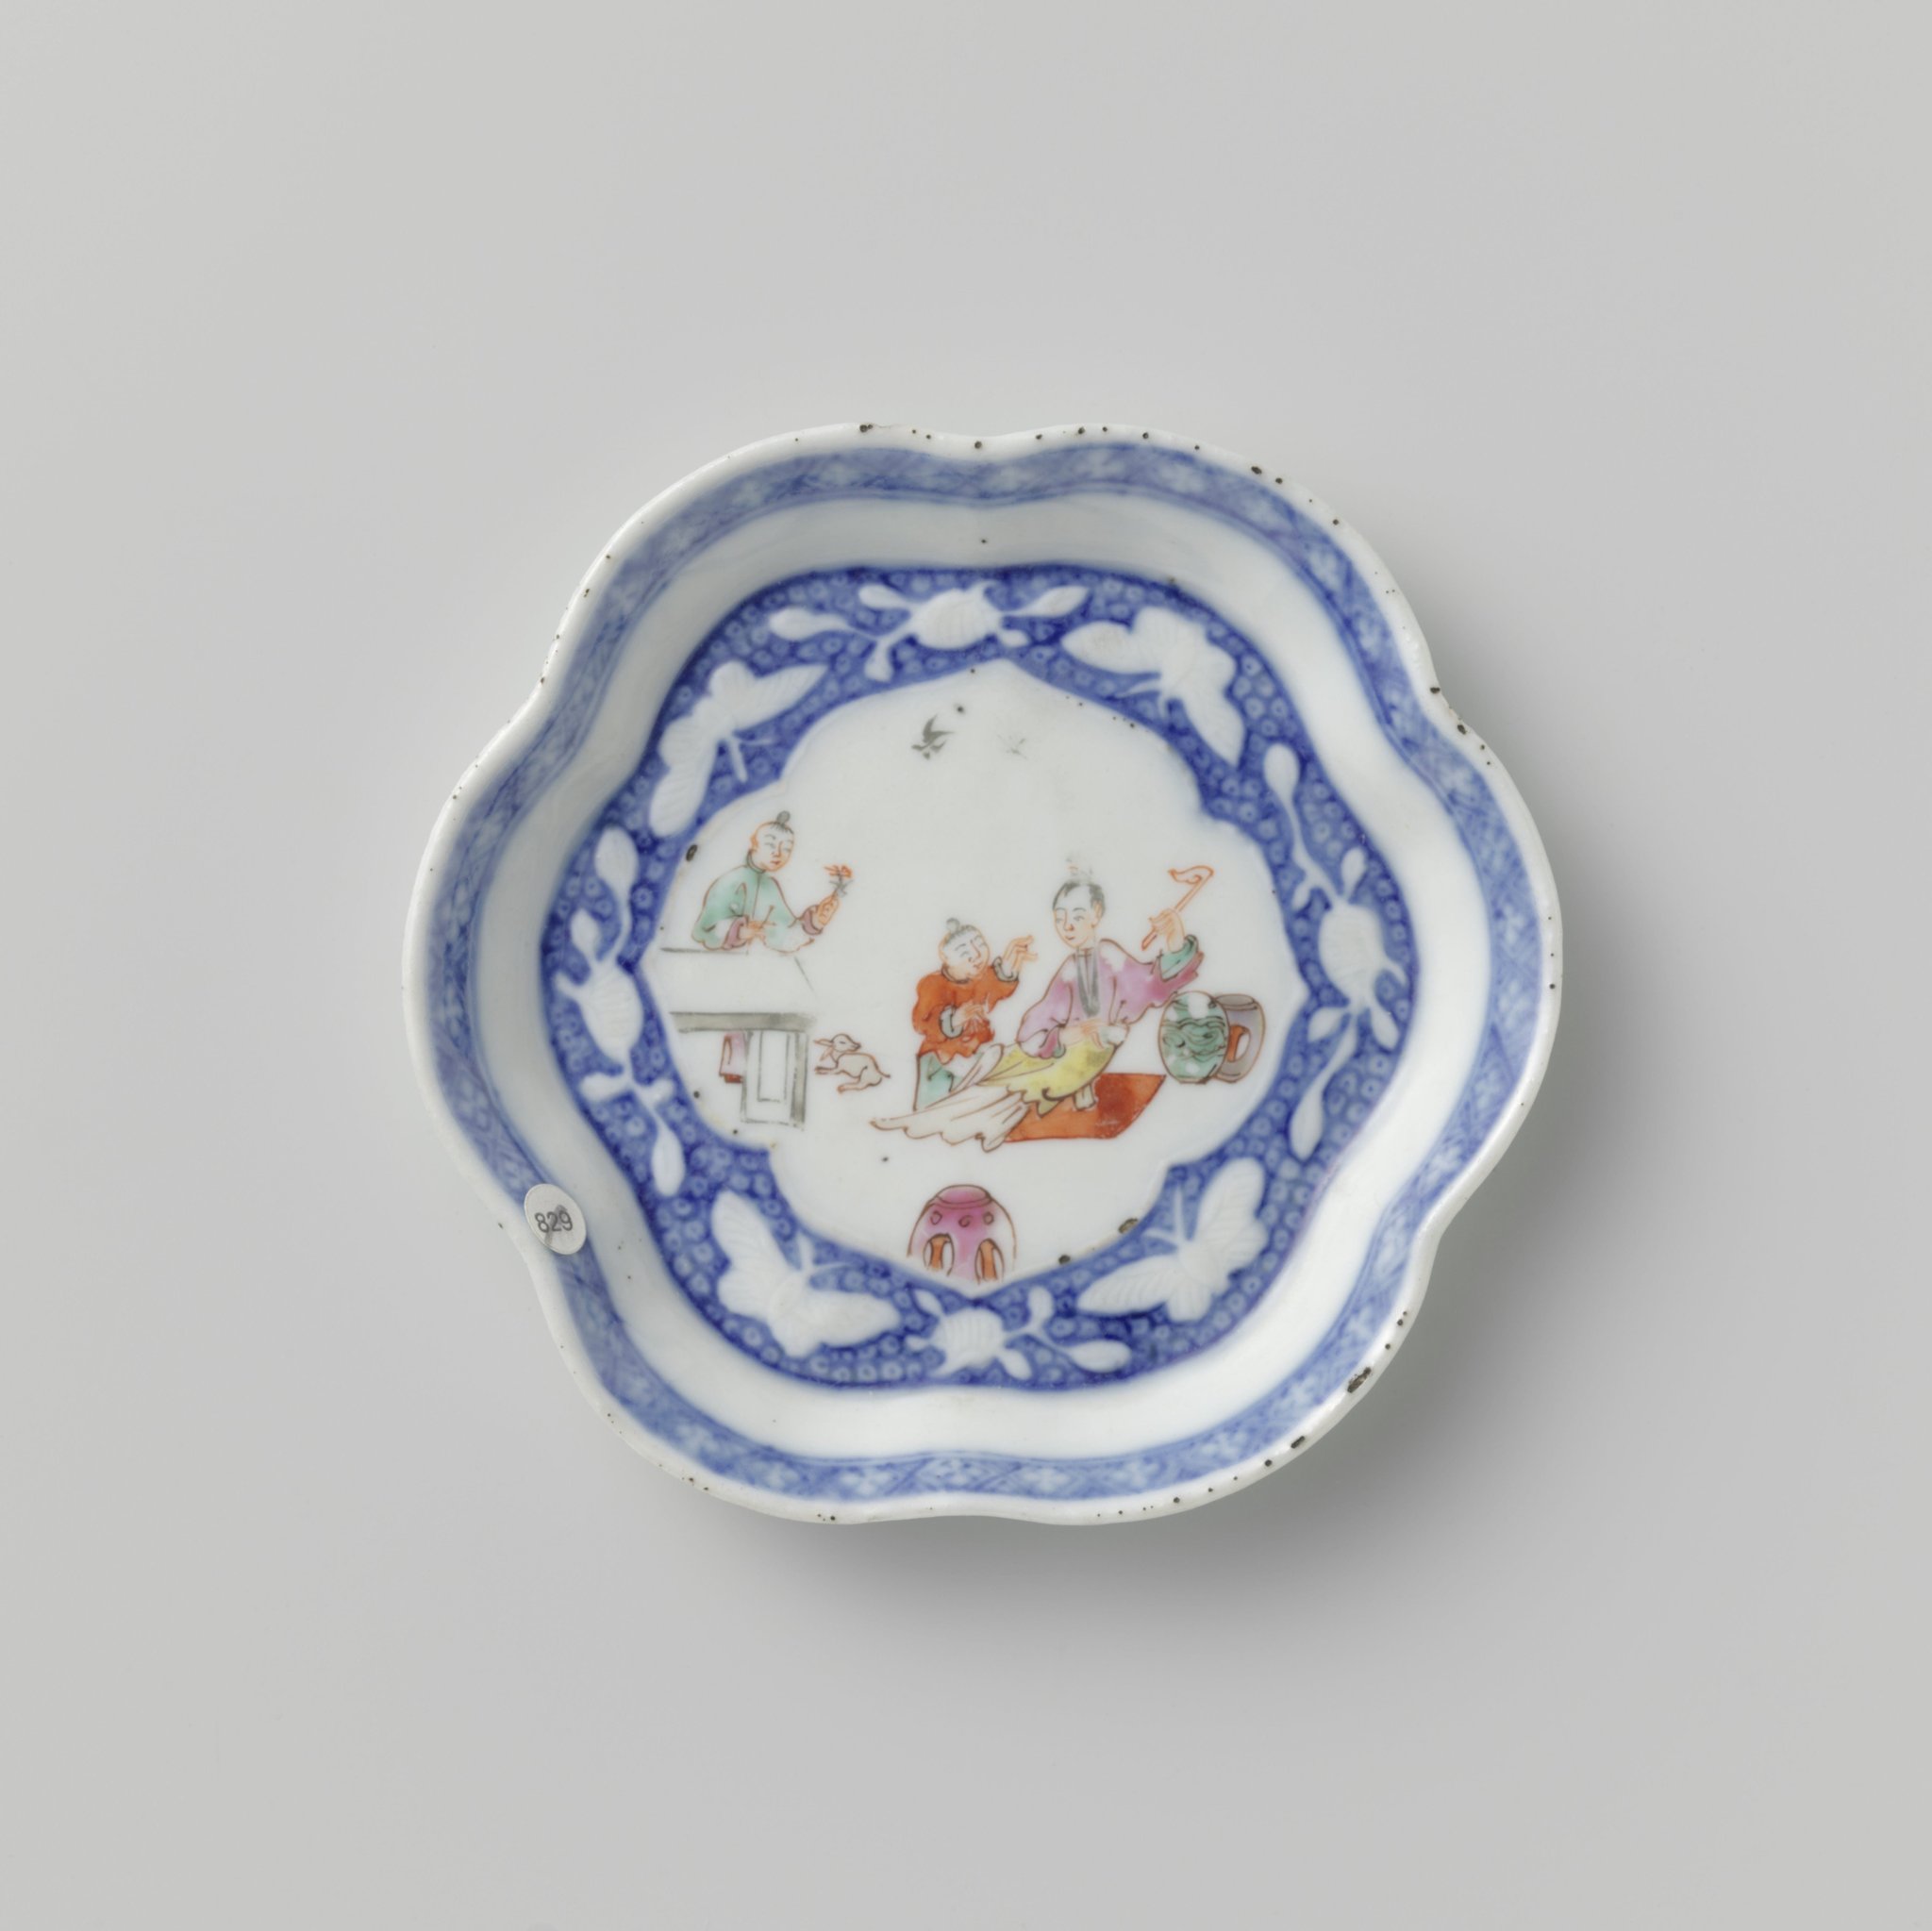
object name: pattipan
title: Teapot stand with two women and a boy with butterflies and flower sprays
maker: Anonymous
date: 1750-1774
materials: glaze, paint, porcelain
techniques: firing, turning, vitrification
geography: china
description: Pattipannetje met blauw en witte rand en gekleurde chinese figuren in het midden.